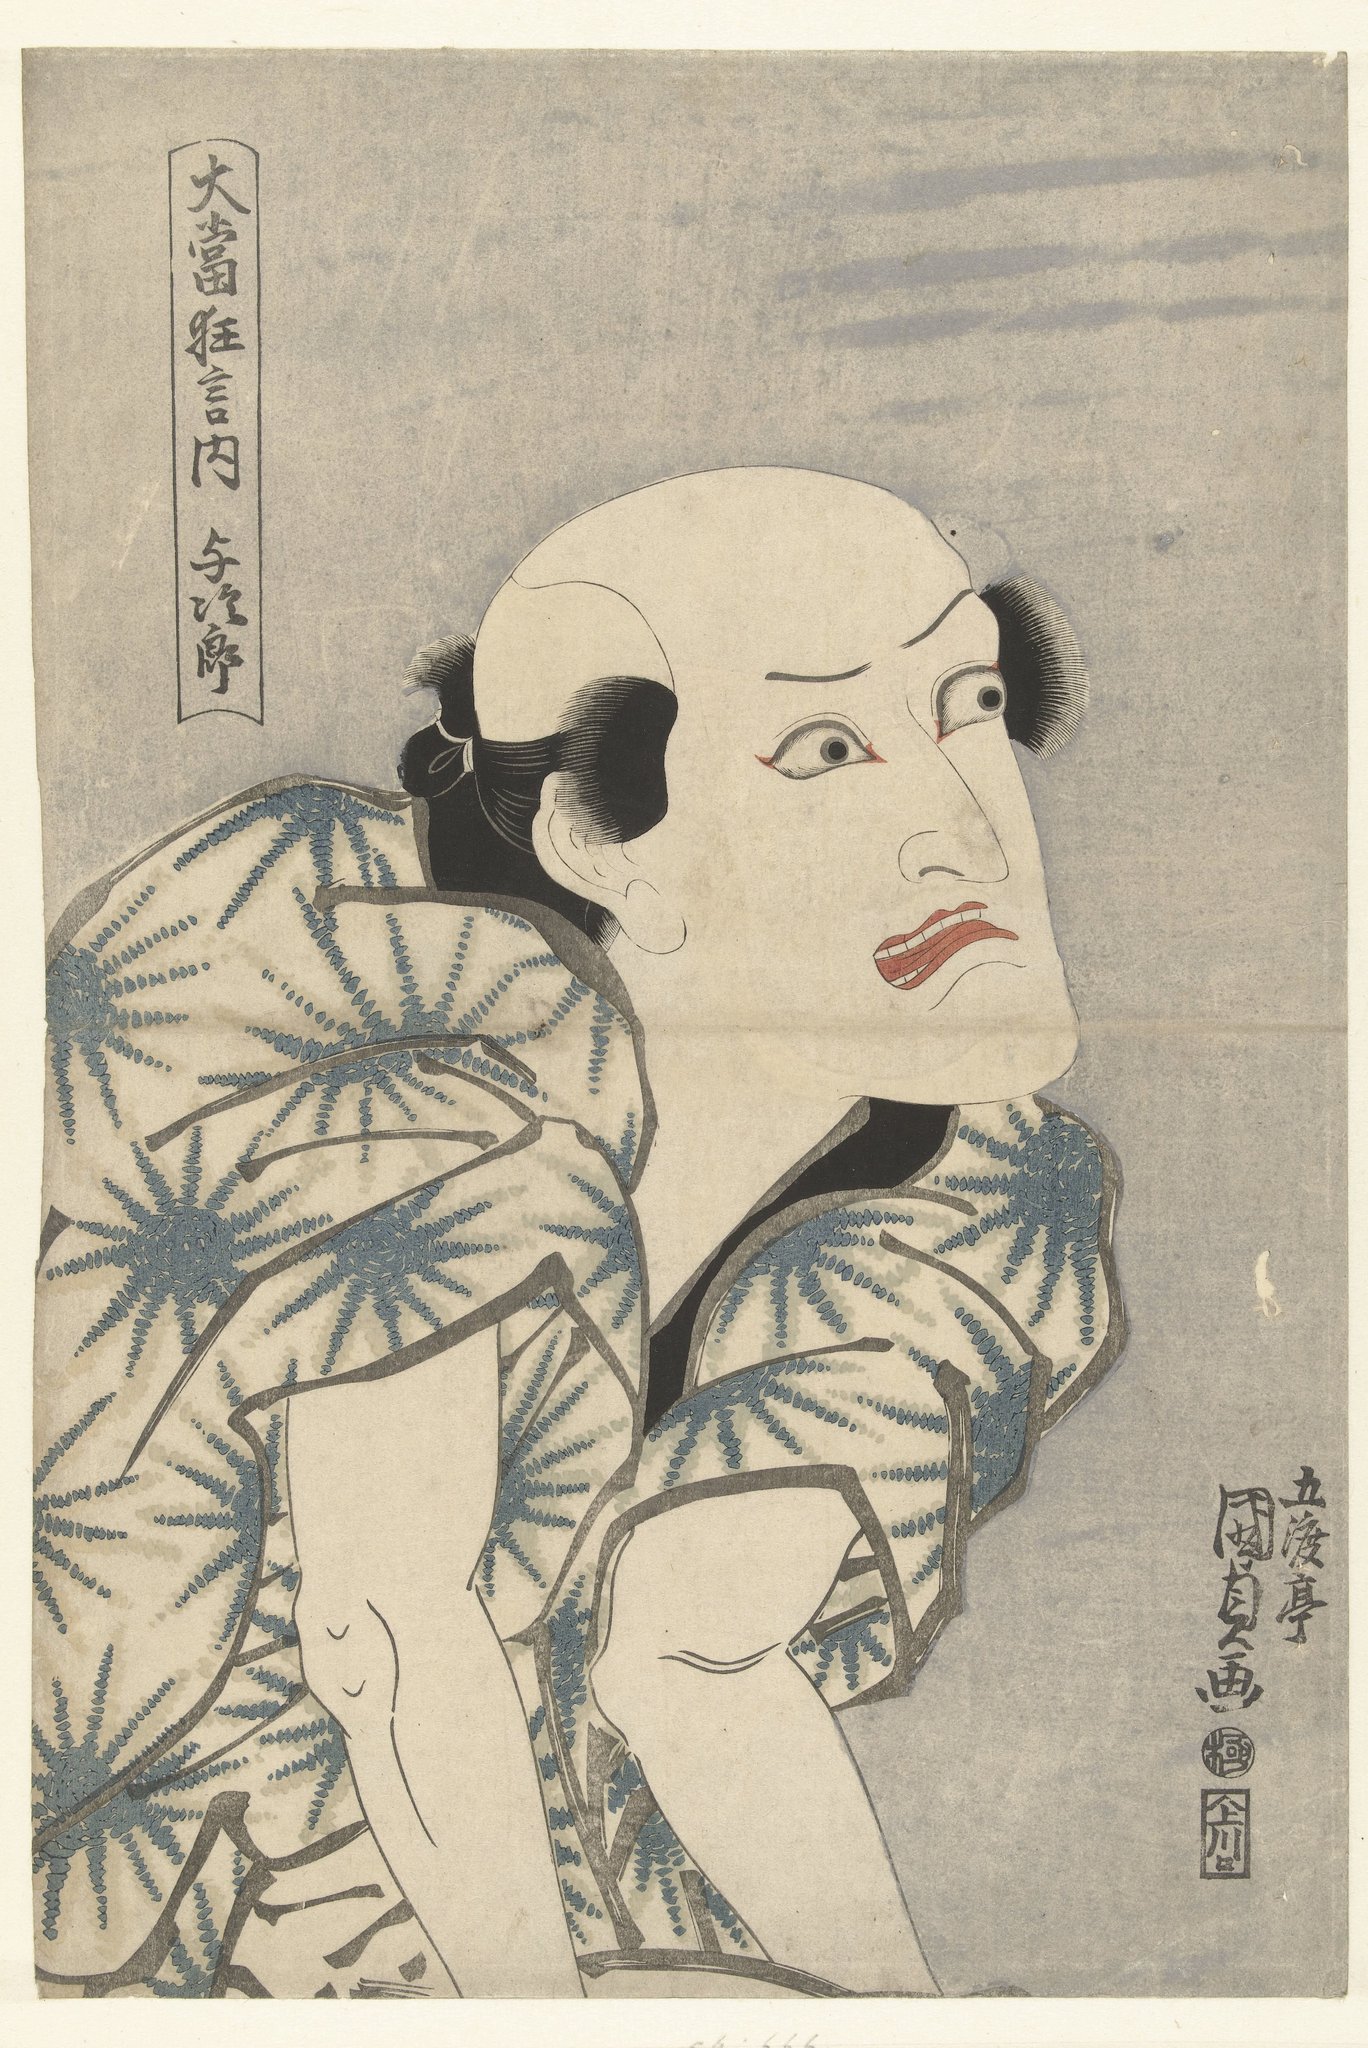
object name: print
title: Nakamura Utaemon III in de rol van Yojiro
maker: utagawa kunisada (i)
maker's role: print maker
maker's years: 1786-1865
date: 1812-1816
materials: paper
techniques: woodcut, nishiki e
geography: japan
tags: portrait of actor, actress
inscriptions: collector's mark: Lugt 2228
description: Busteportet van de acteur Nakamura Utaemon III in de rol van Yojir, in kimono met patroon van blauwe zeesterren; tegen mica achtergrond.